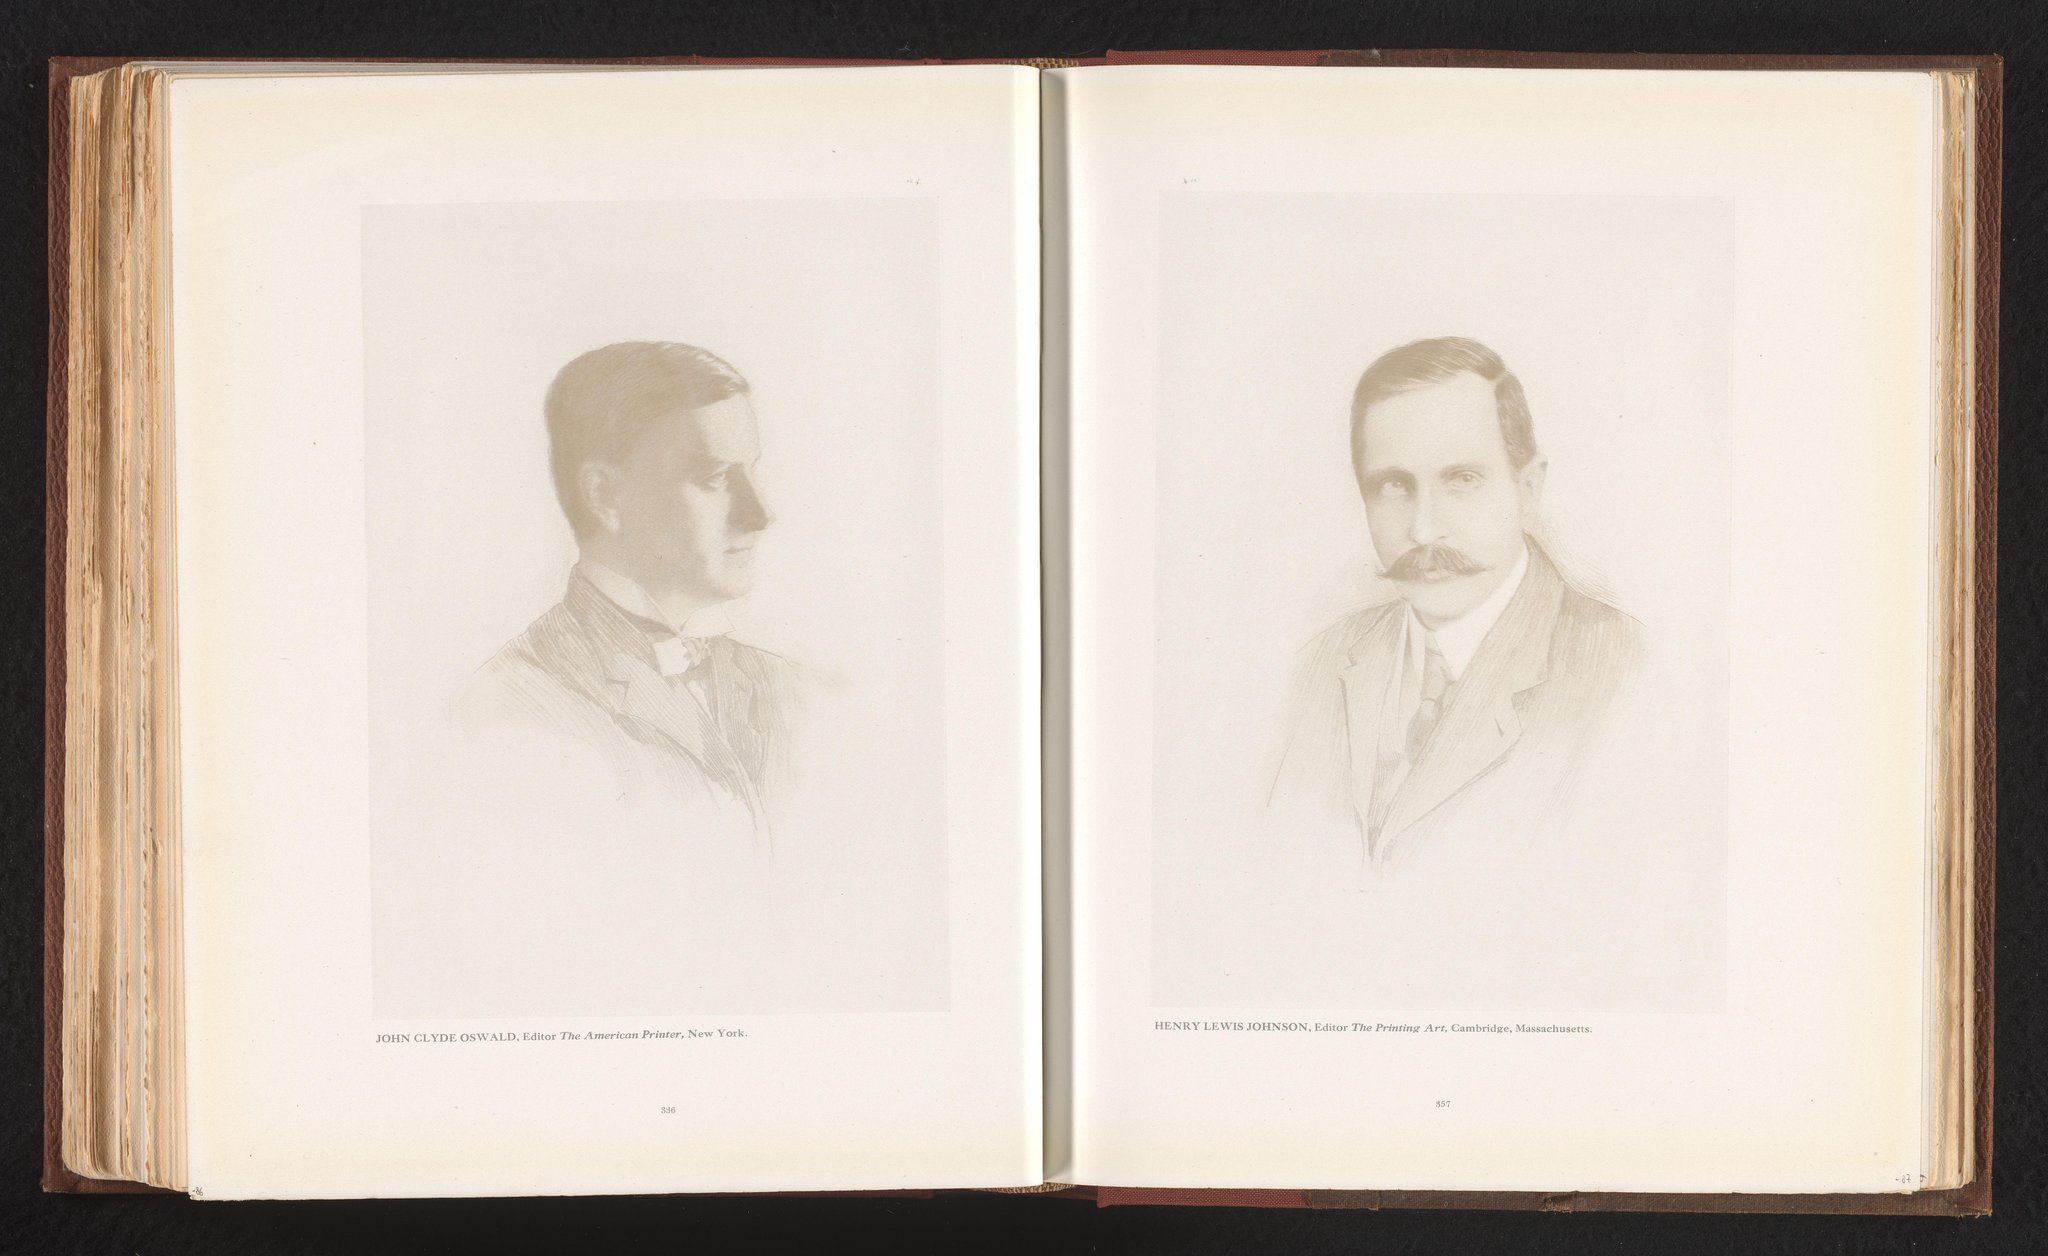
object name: page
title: Reproductie van een geretoucheerde fotoreproductie met een portret van John Clyde Oswald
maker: Anonymous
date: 1904-1909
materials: paper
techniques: autotype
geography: columbus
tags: adult man, historical persons